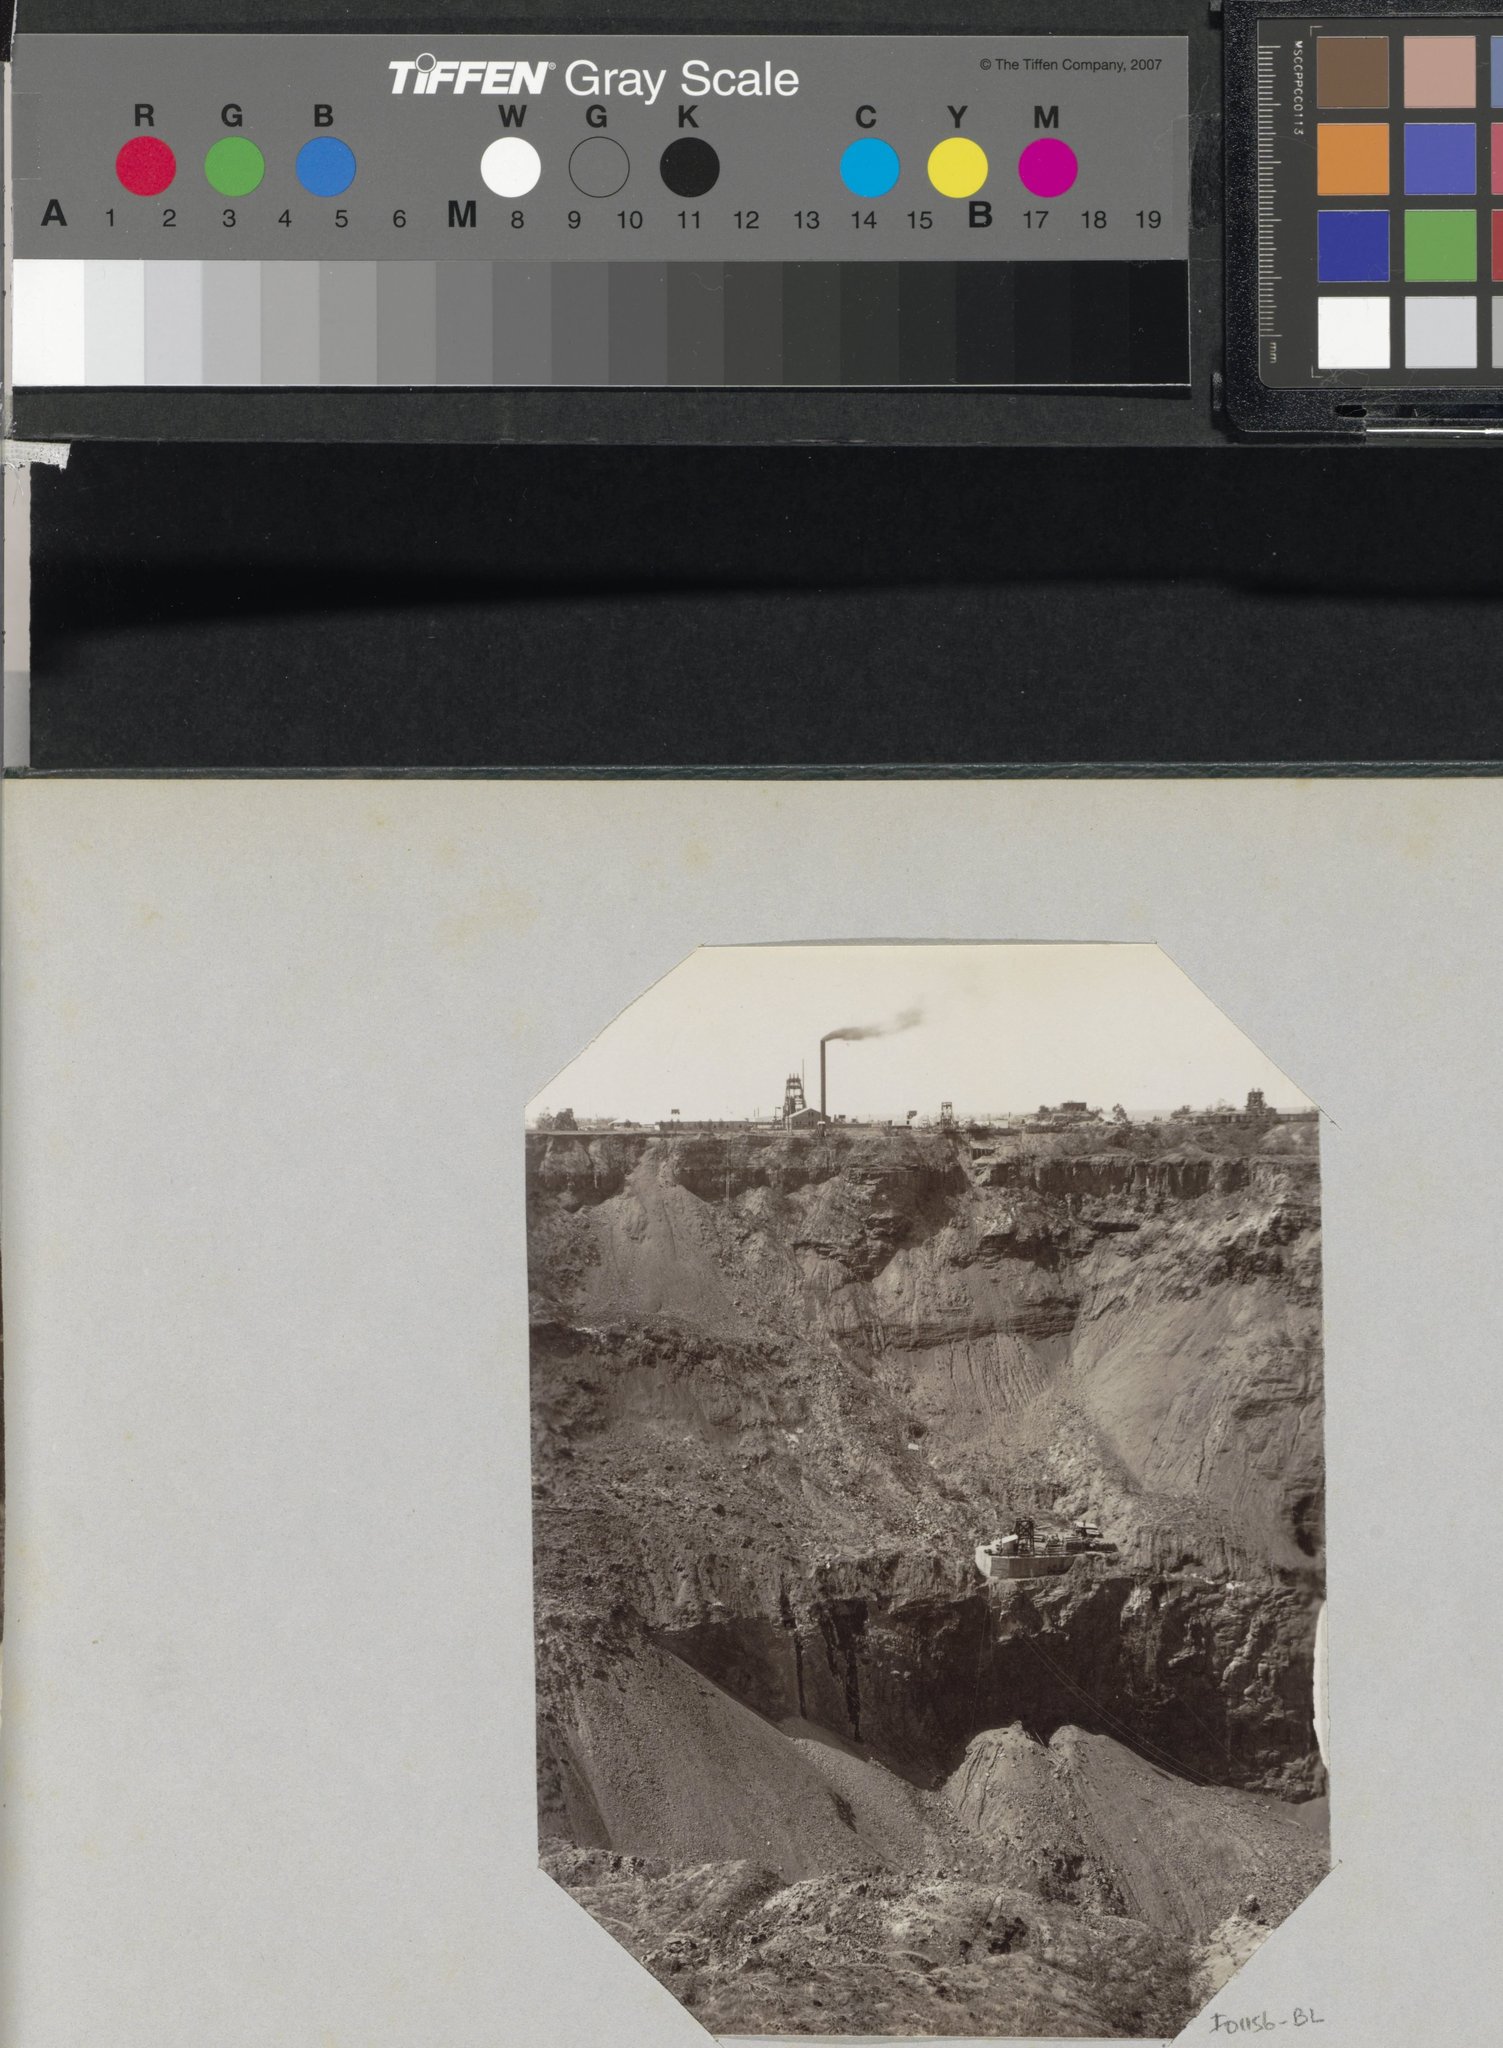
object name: album leaf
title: Steengroeve van een diamantmijn te Kimberley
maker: charles h. evans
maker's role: fotograaf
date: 1896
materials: photographic support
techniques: albumen print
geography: kimberley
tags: quarry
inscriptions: annotation: ‘Kimberley, uitwendige mijn/ 2-7 april 1896’, inscription: ‘C. Evans/ Photographer/ Du Toit's Pan Road/ Kimberley’